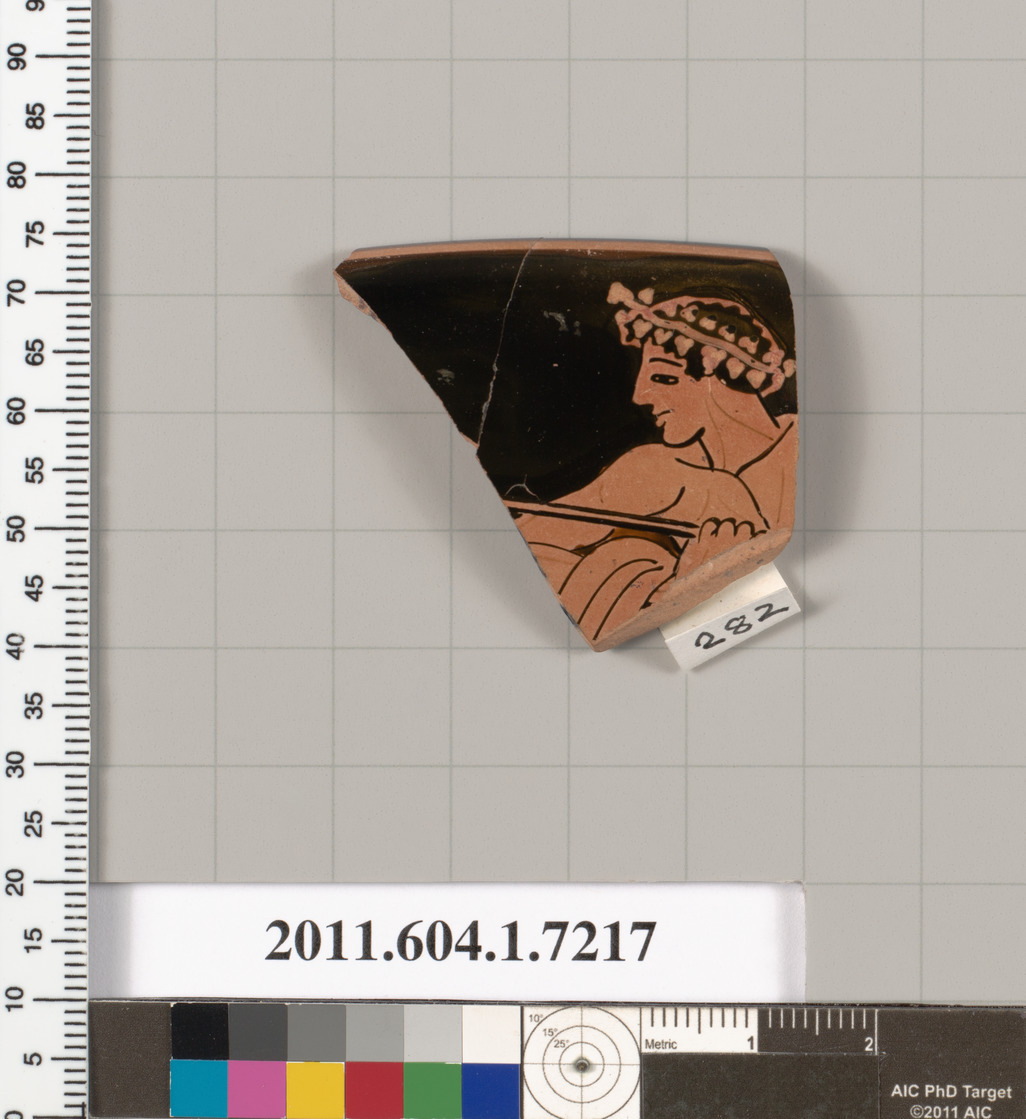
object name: kylix fragment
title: Terracotta rim fragment of a kylix (drinking cup)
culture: greek, attic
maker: makron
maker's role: artist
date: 500-480 BCE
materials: terracotta